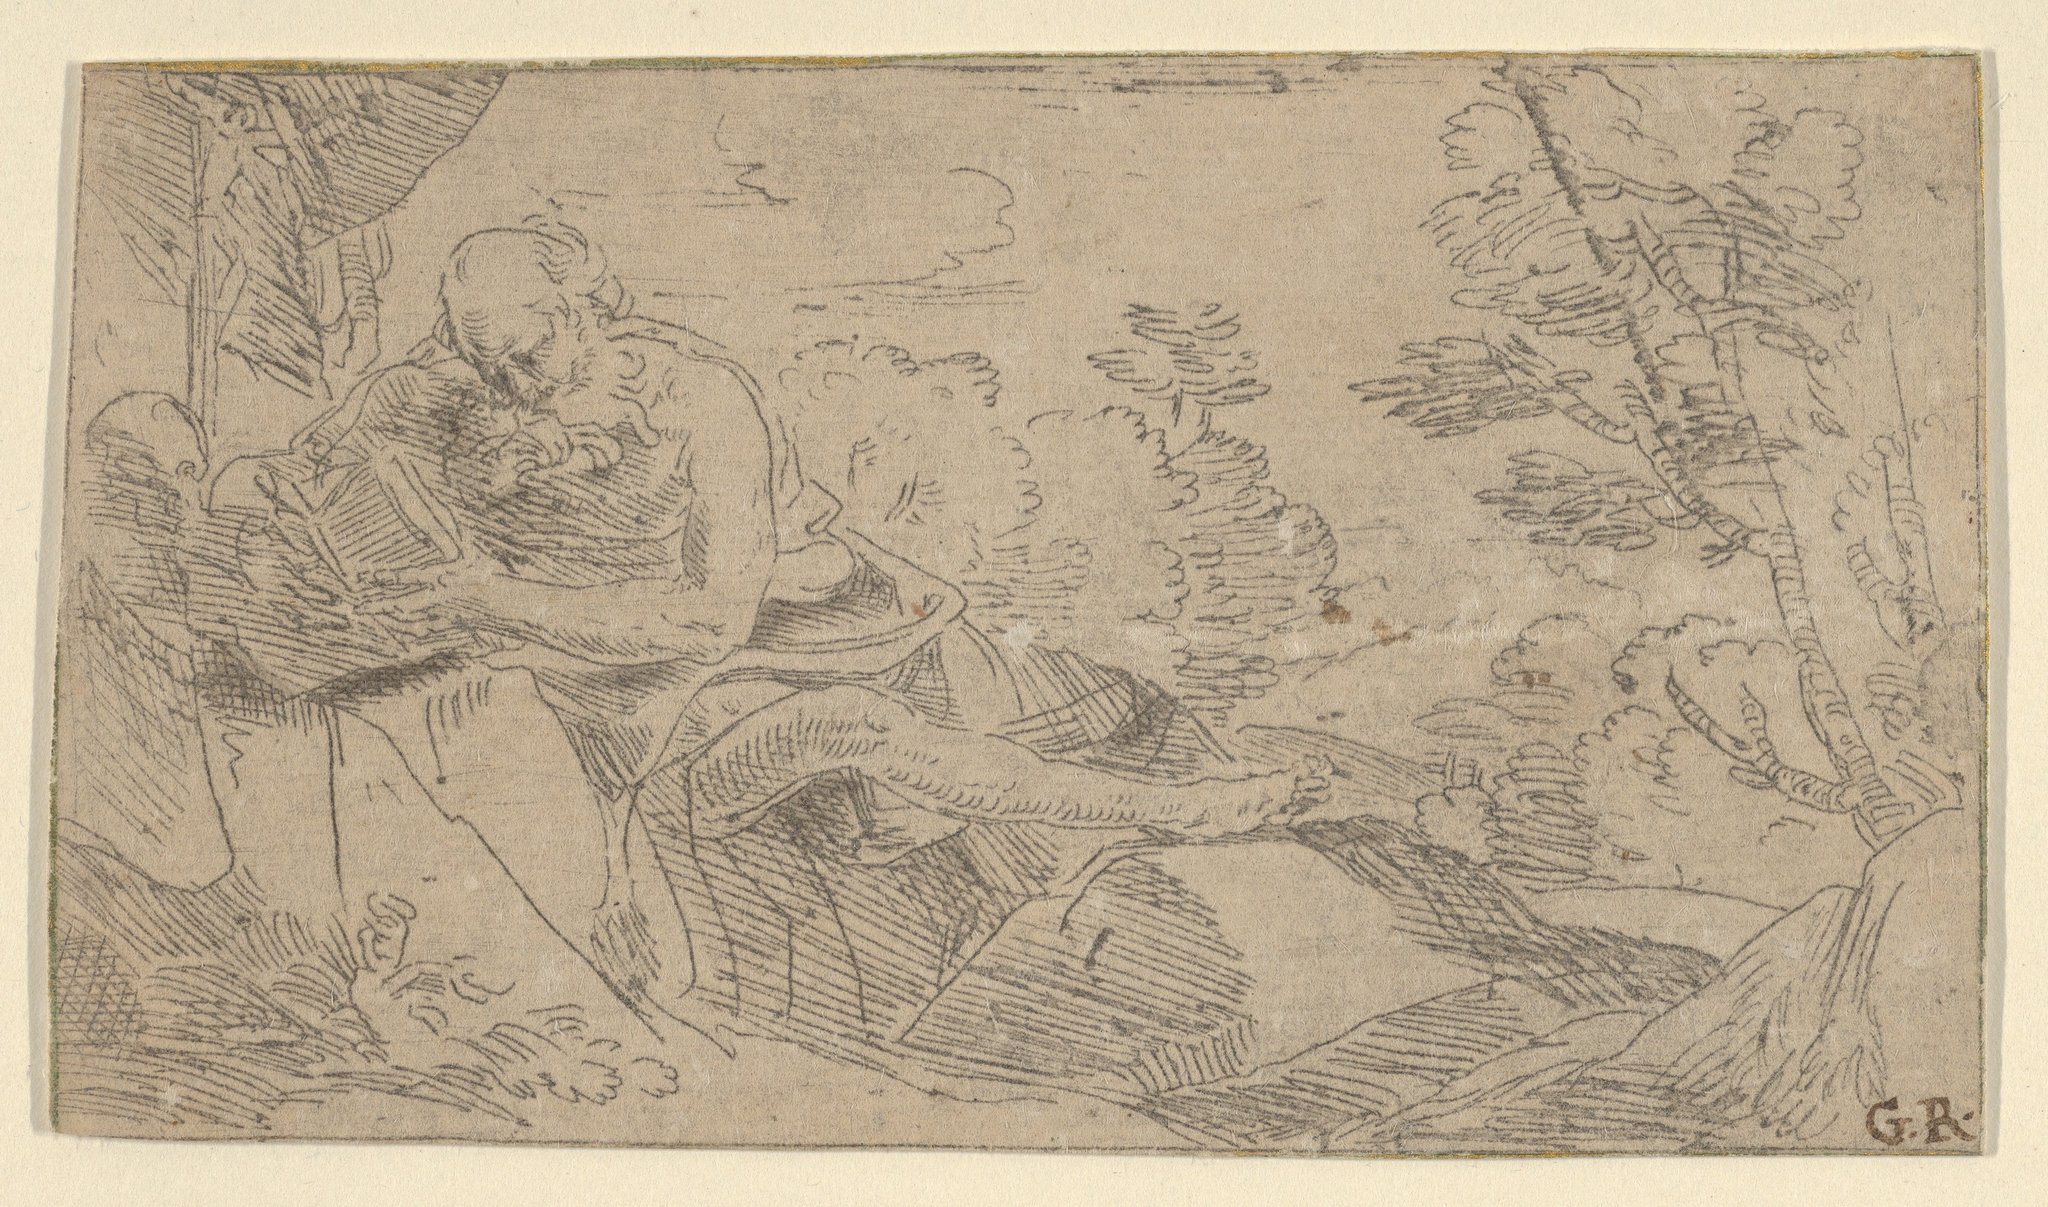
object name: print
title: Saint Jerome seated on rocks and reading a book, a cross and a skull at left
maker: Anonymous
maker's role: artist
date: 1601-1700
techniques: etching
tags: books,reading,saint jerome